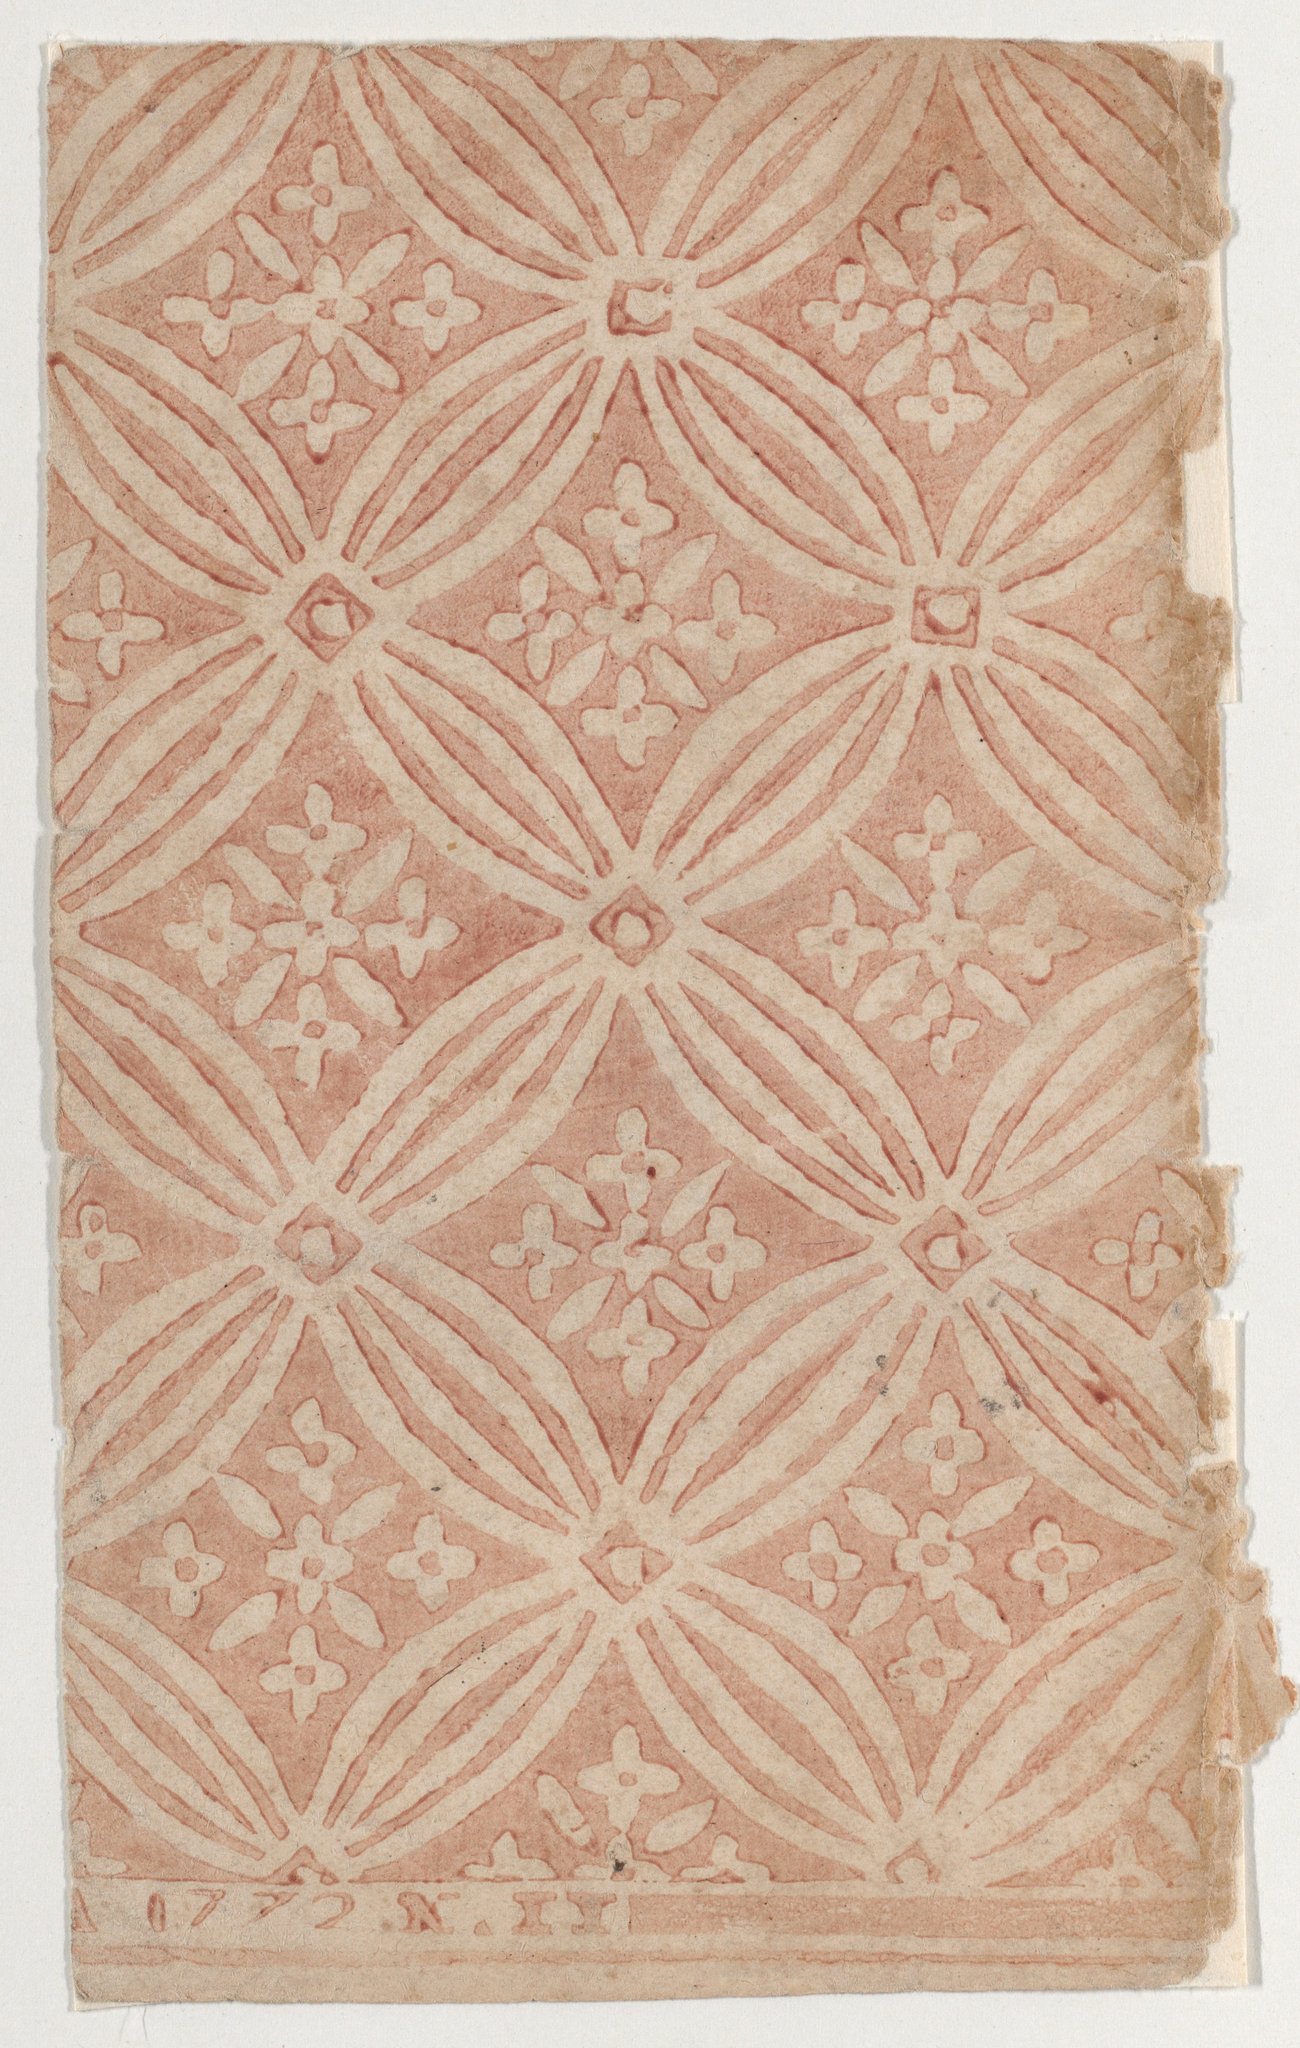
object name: print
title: Sheet with overall red floral pattern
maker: Anonymous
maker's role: artist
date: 1701-1800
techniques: relief print